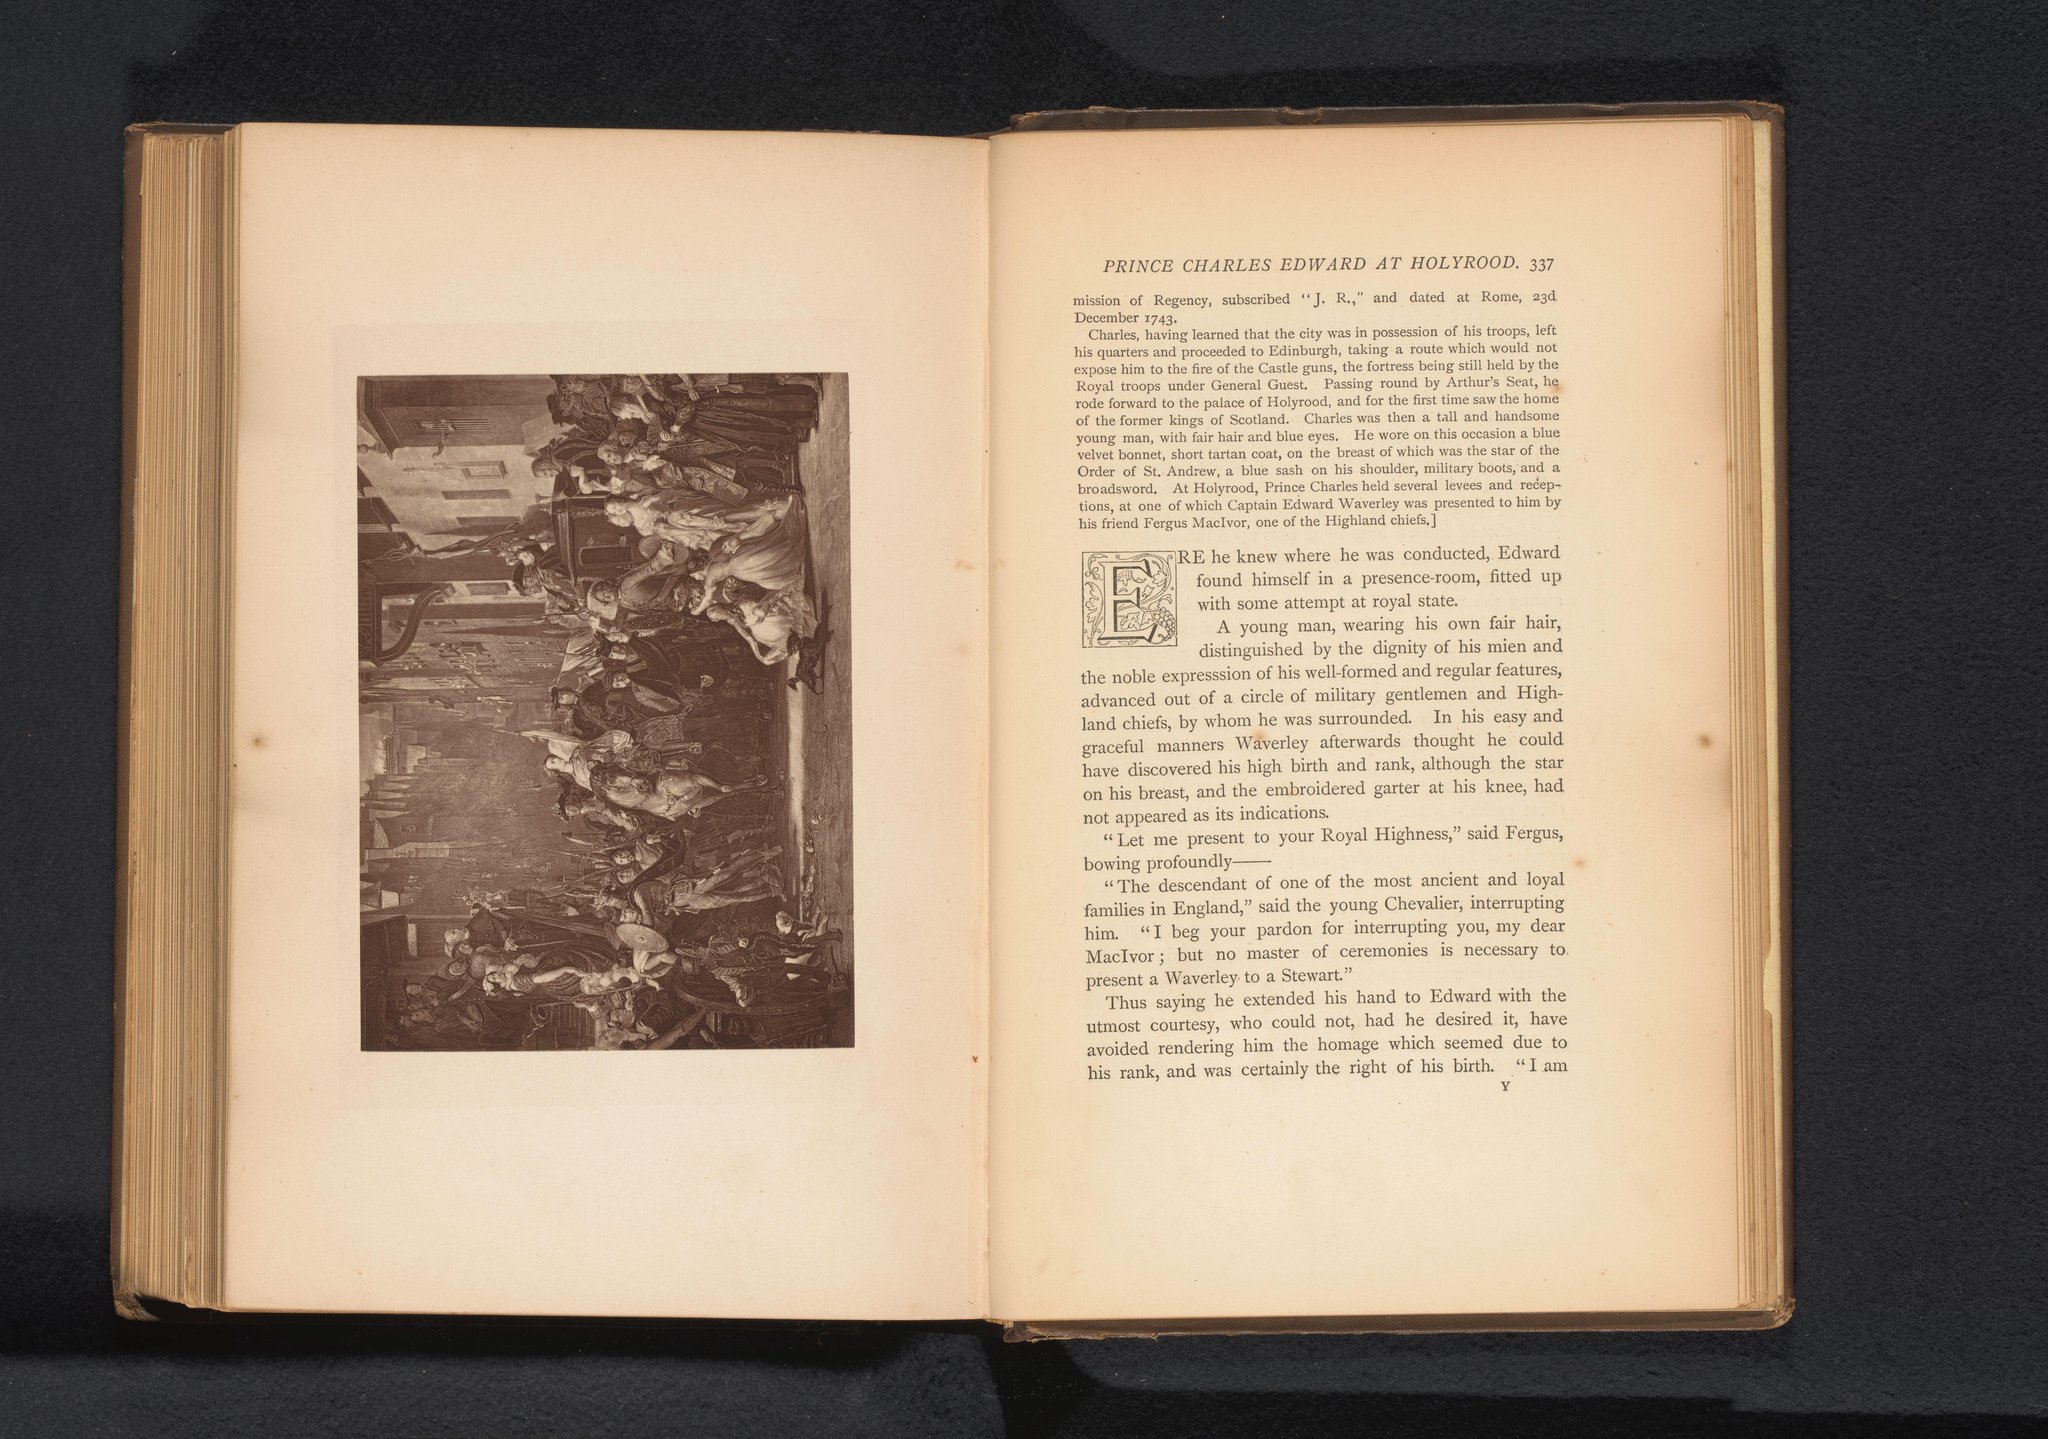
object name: photomechanical print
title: The entry of prince Charles Edward into Edinburgh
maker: Anonymous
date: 1876-1881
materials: paper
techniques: woodburytype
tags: usurpation, march into the conquered place